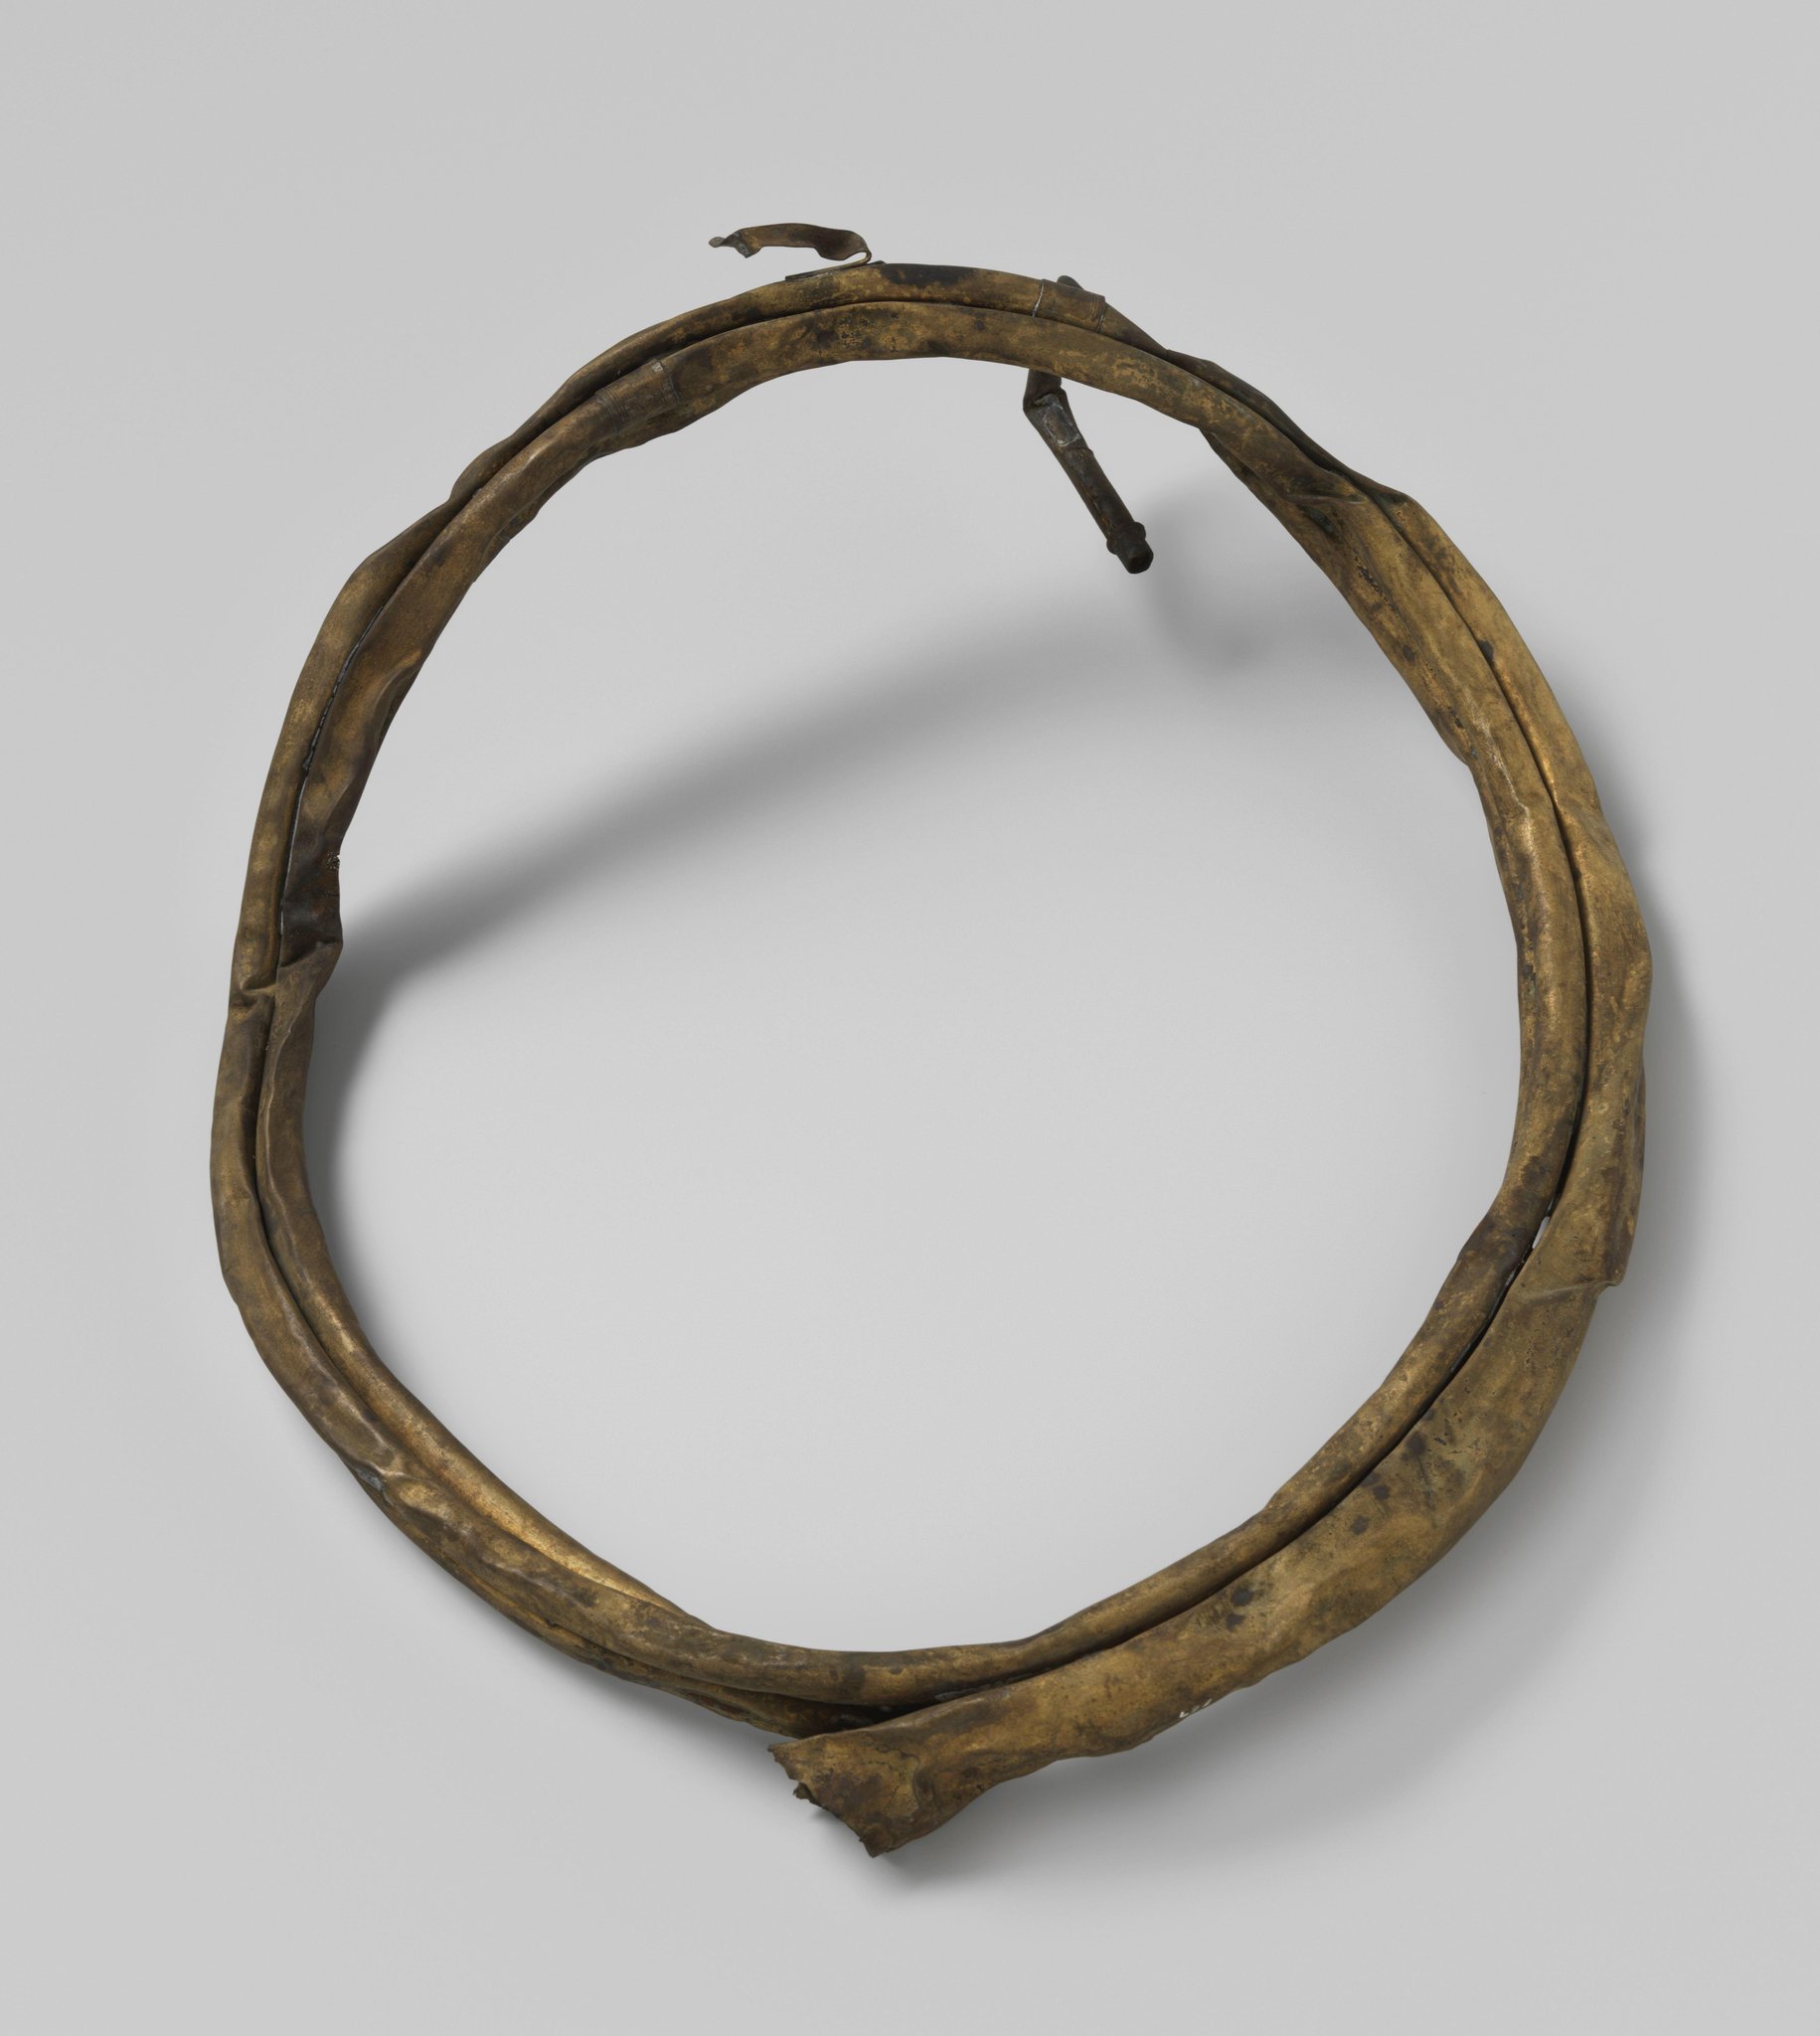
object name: natural horn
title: Natural horn (fragment)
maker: johann heinrich eichentopf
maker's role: musical instrument maker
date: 1732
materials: brass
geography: leipzig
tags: 't vliegend hart (schip), verenigde oostindische compagnie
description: Ronde dubbele buis; onderdeel van een natuurhoorn uit het wrak van de Oostindiëvaarder TVliegend Hart.